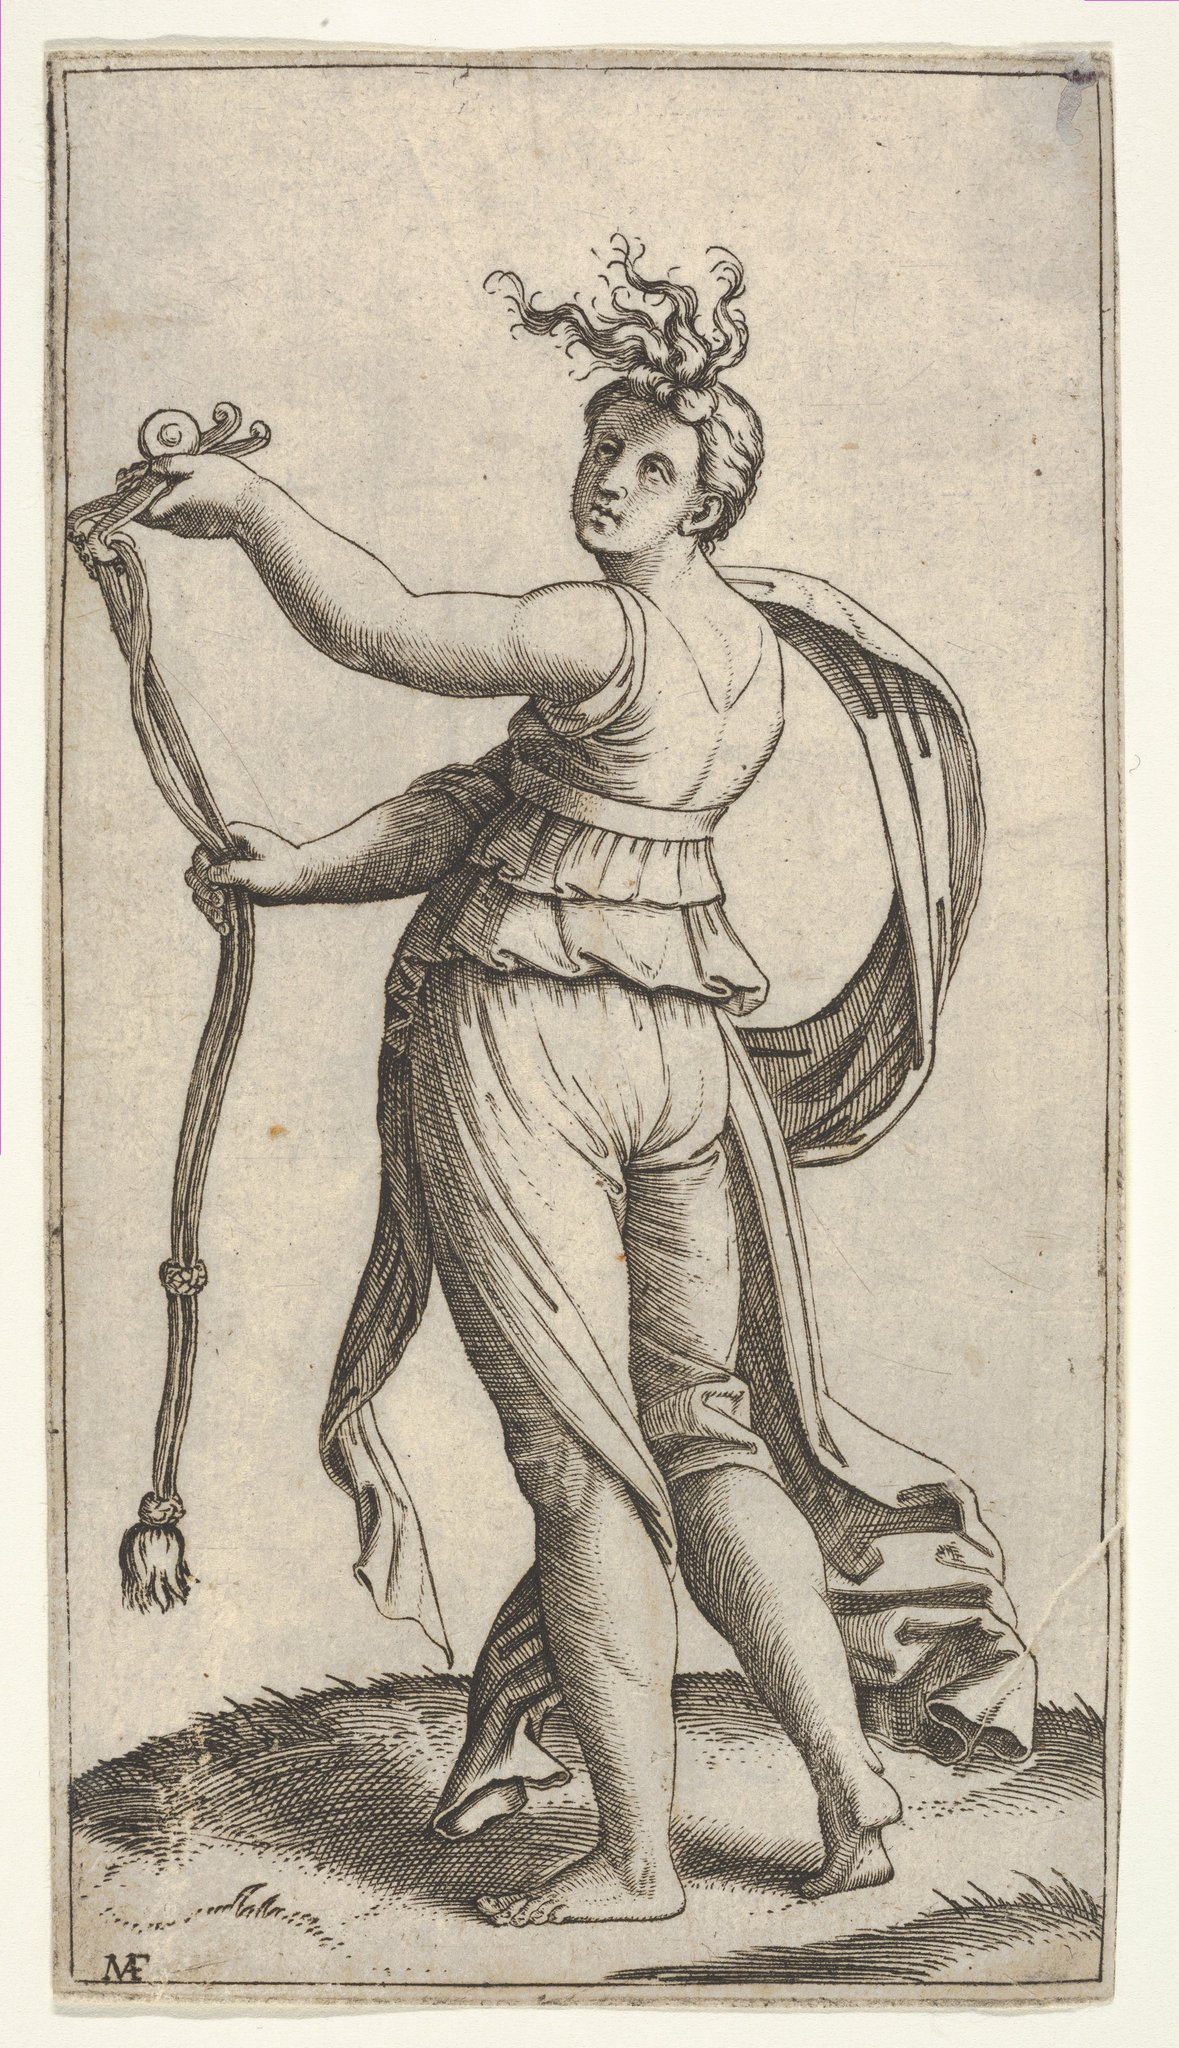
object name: print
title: A woman representing Temperance holding a bit facing left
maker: marcantonio raimondi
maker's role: artist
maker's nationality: italian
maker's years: 1475-1534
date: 1510-1527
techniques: engraving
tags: portraits,women